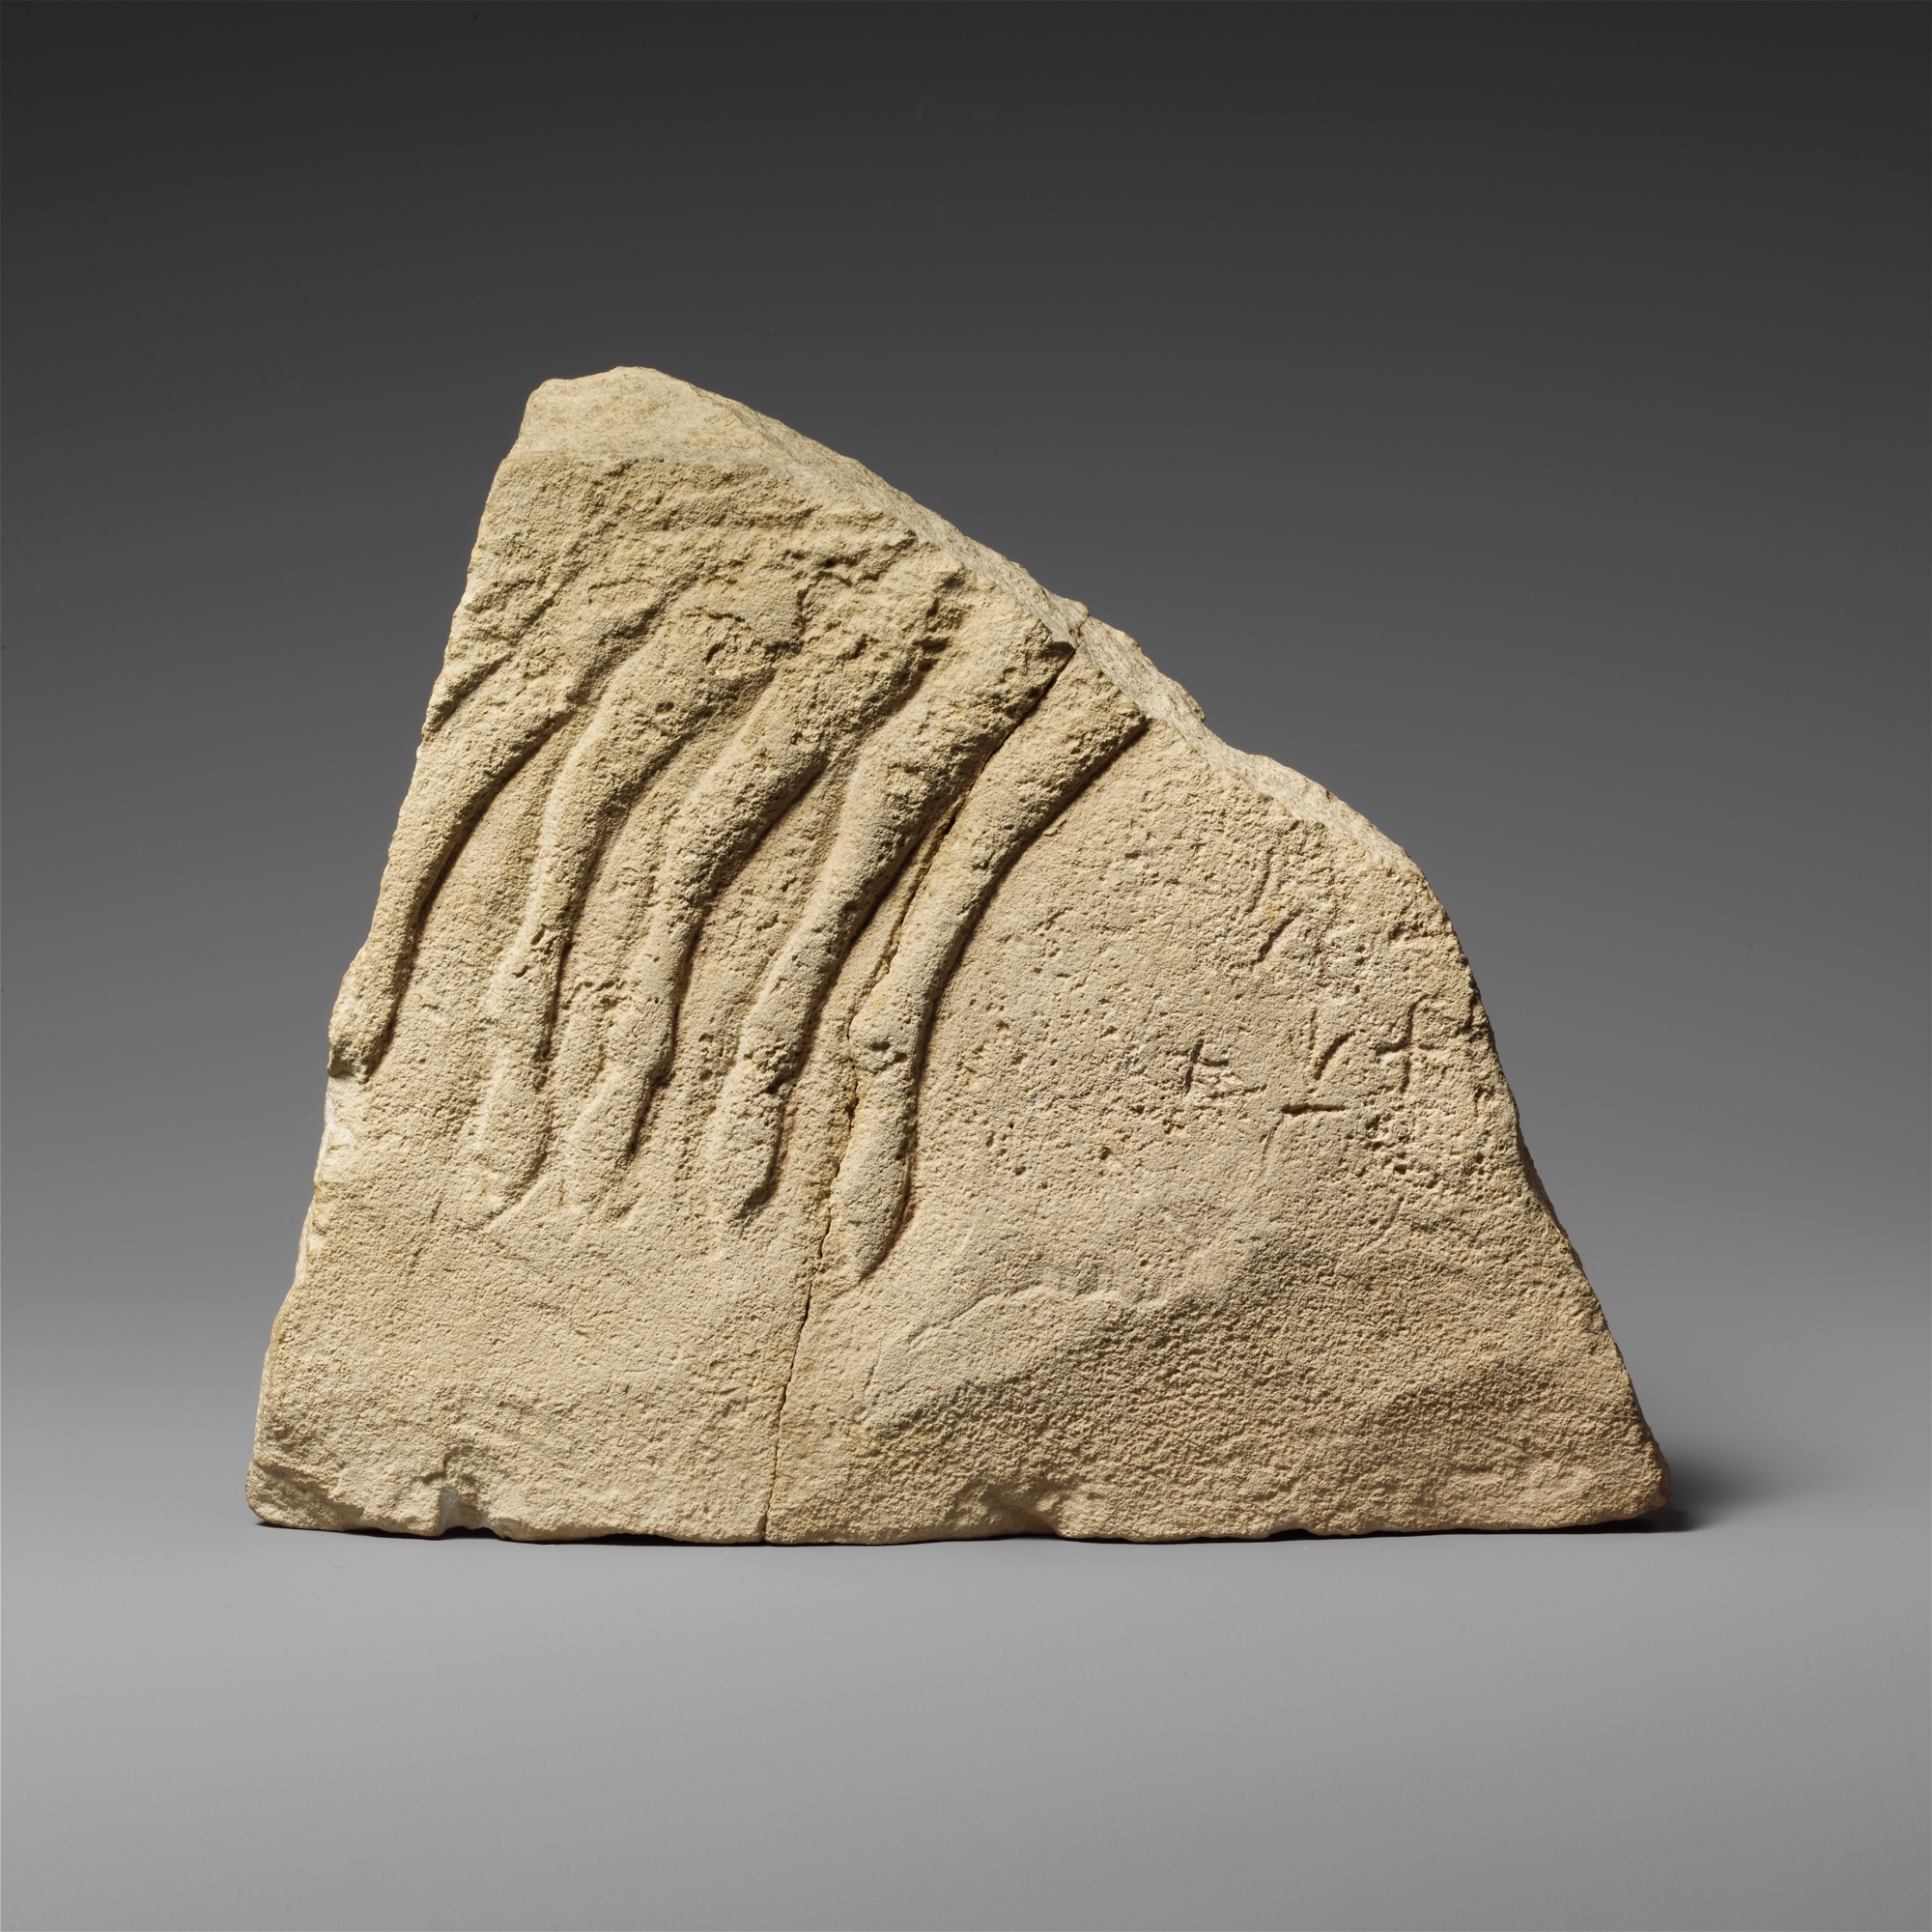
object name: relief of horse leg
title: Fragment of a limestone votive relief with a quadriga (?)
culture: cypriot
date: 400-301 BCE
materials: limestone